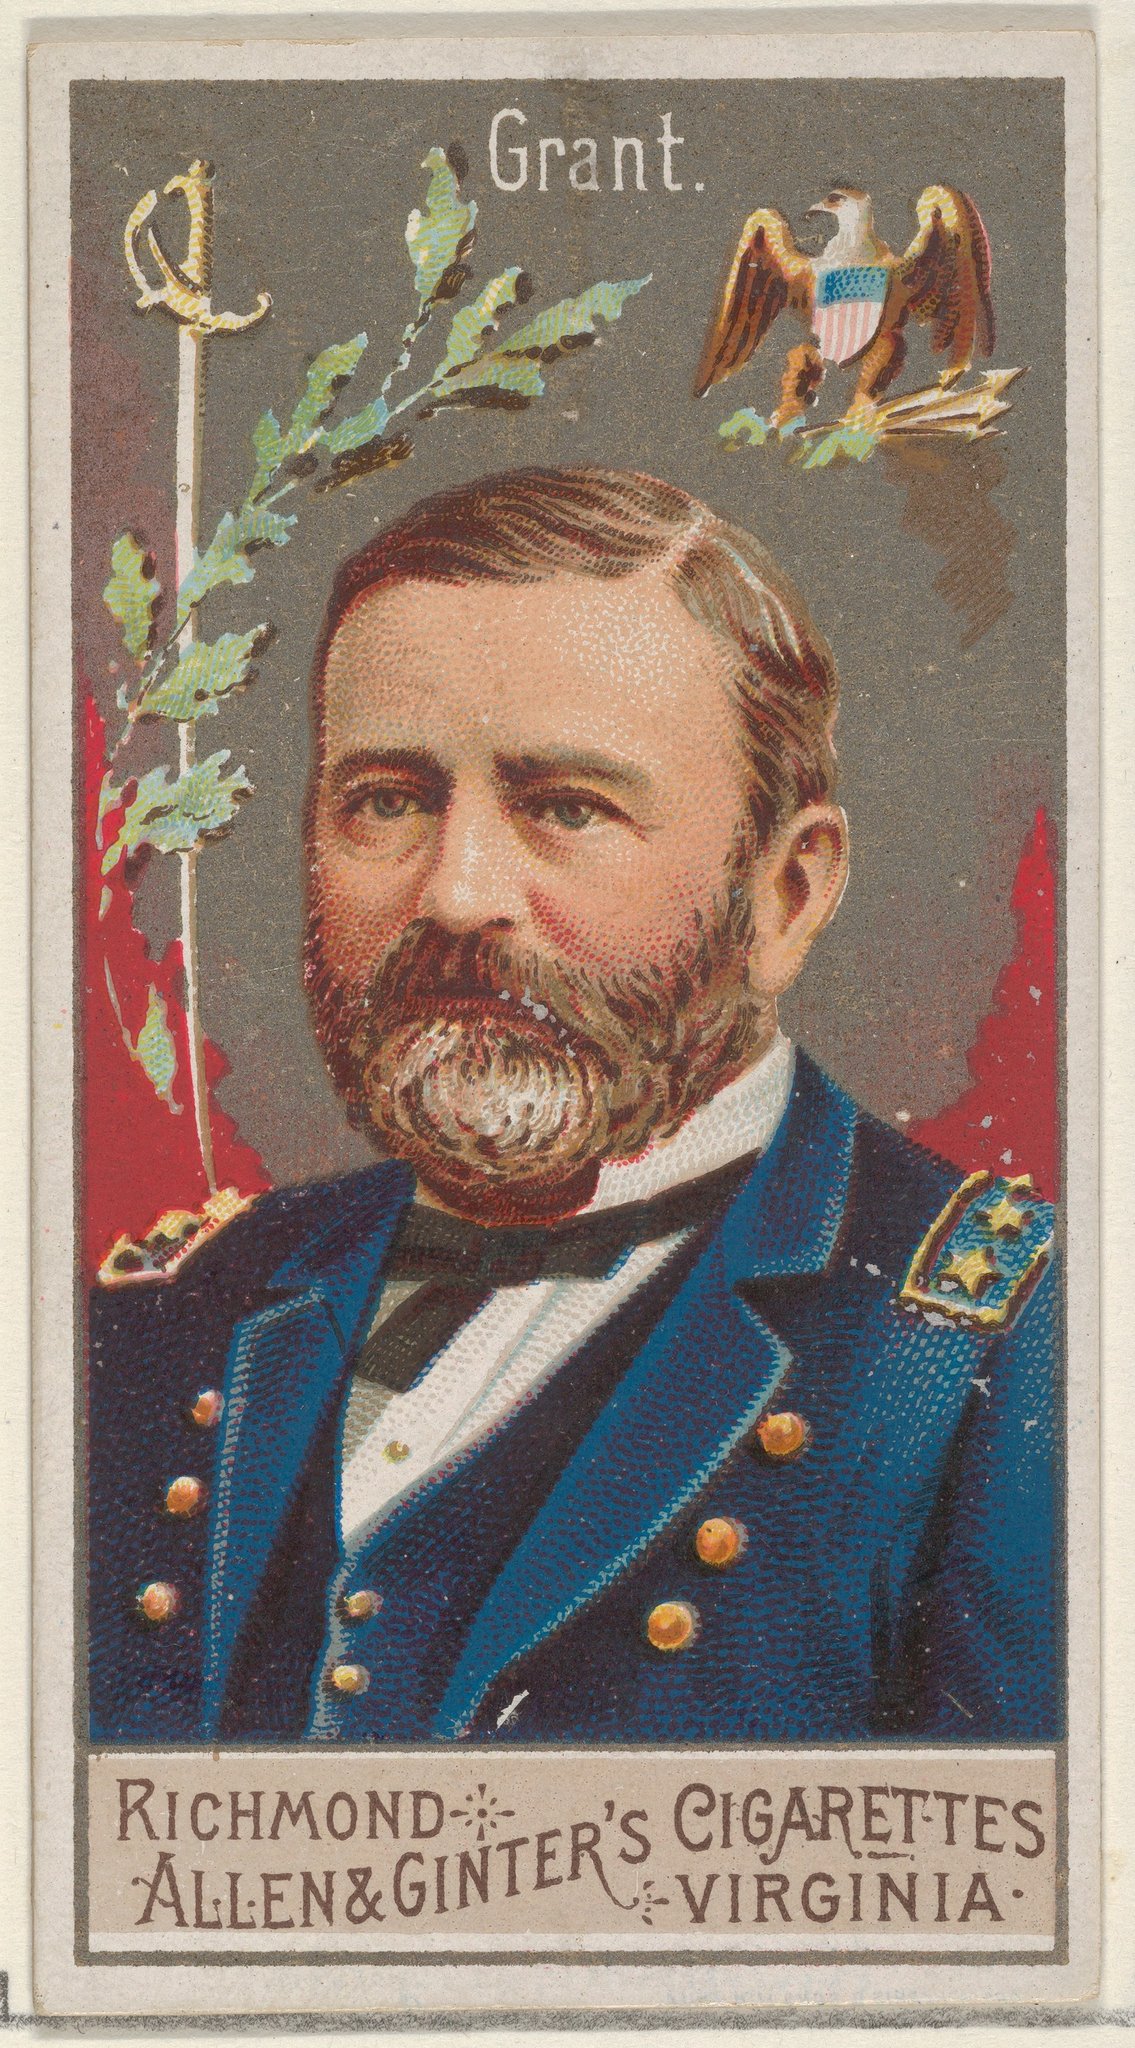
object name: print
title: Ulysses S. Grant, from the Great Generals series (N15) for Allen & Ginter Cigarettes Brands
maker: allen & ginter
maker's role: publisher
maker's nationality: american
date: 1888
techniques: color lithograph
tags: men,generals